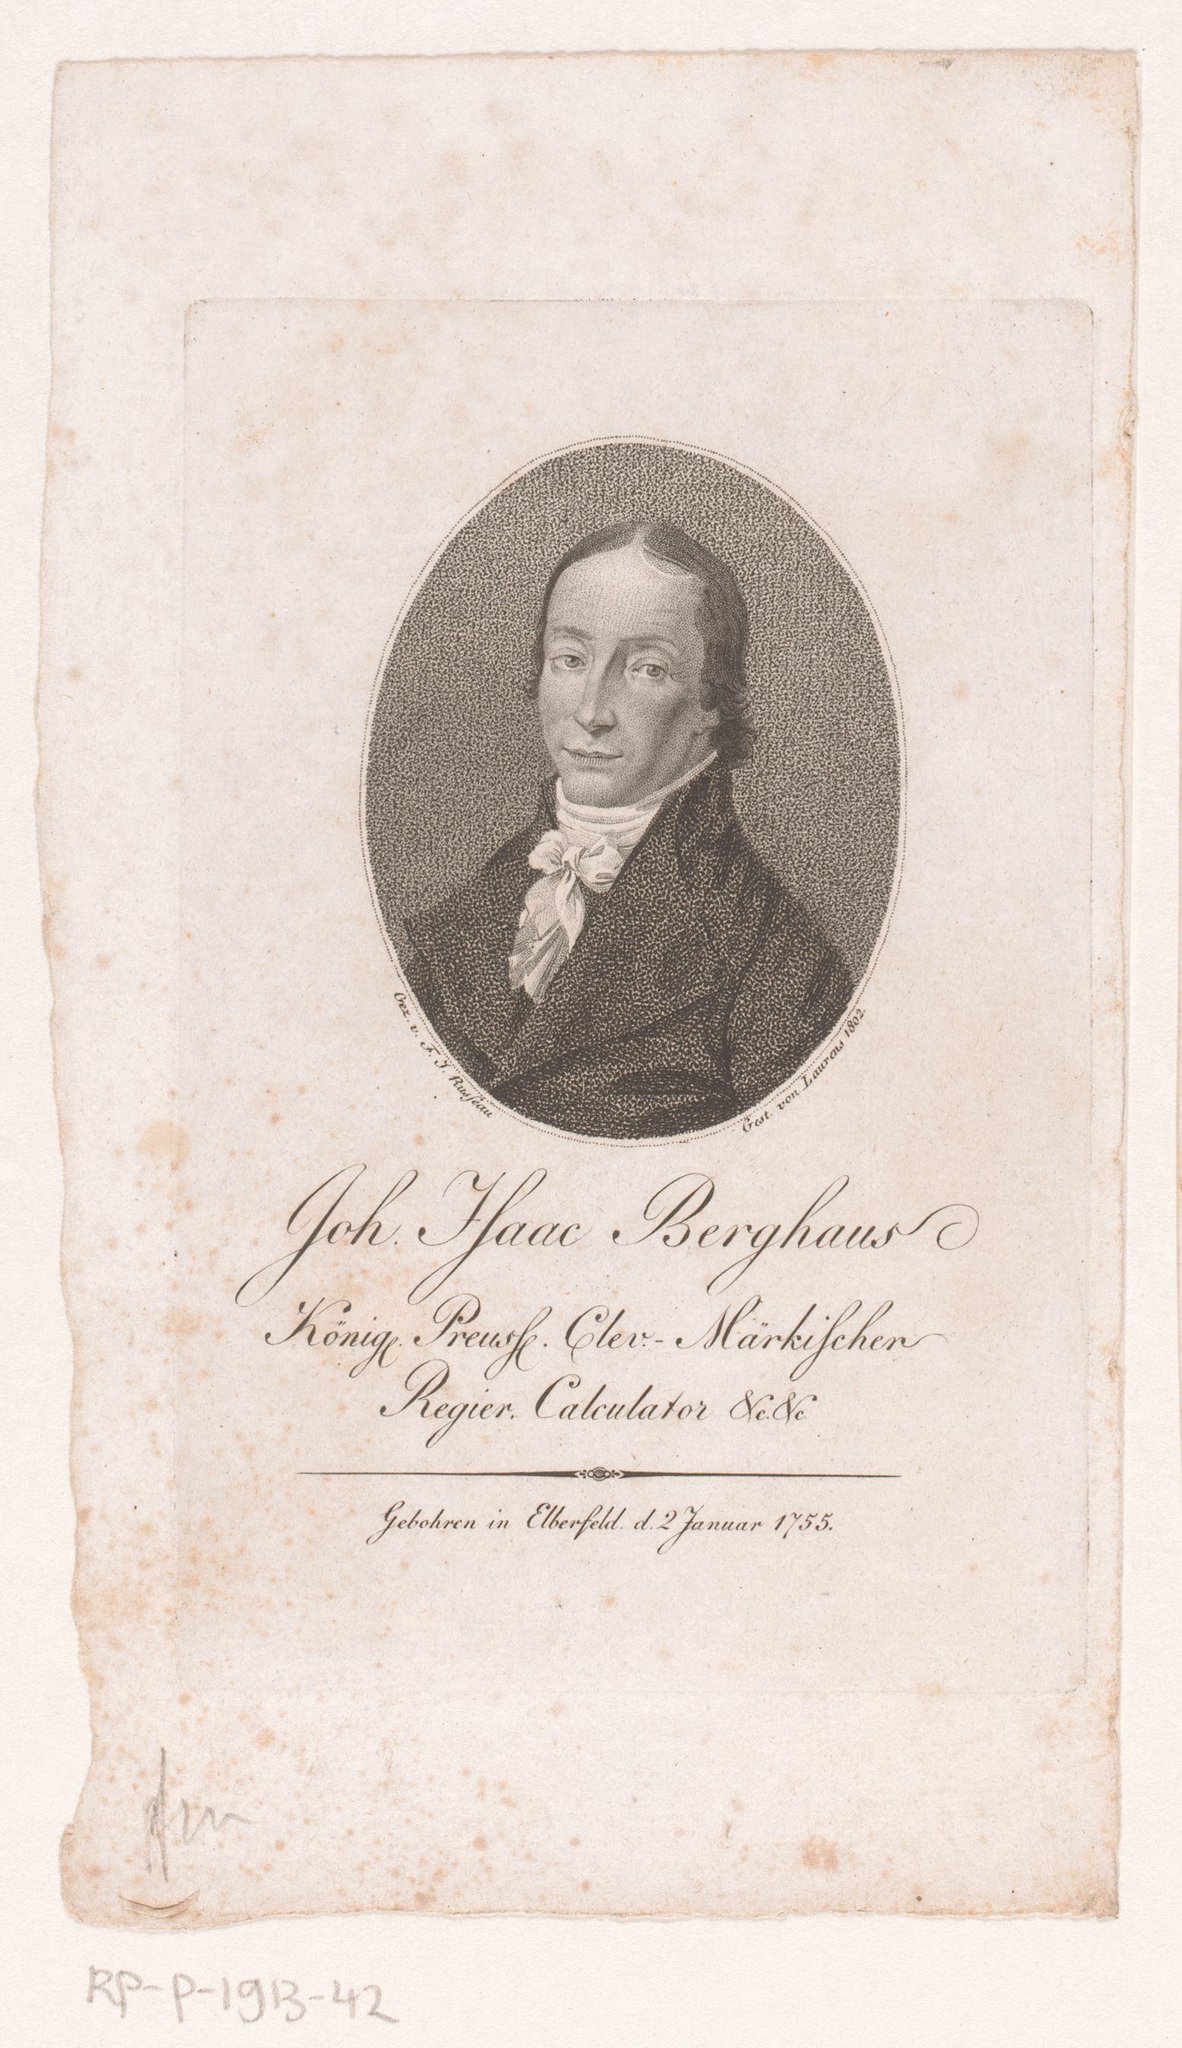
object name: print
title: Portret van Johann Isaac Berghaus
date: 1802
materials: paper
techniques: stippling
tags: history and archaeology (+ portrait of scholar, scientist), historical persons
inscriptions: collector's mark: Lugt 2228